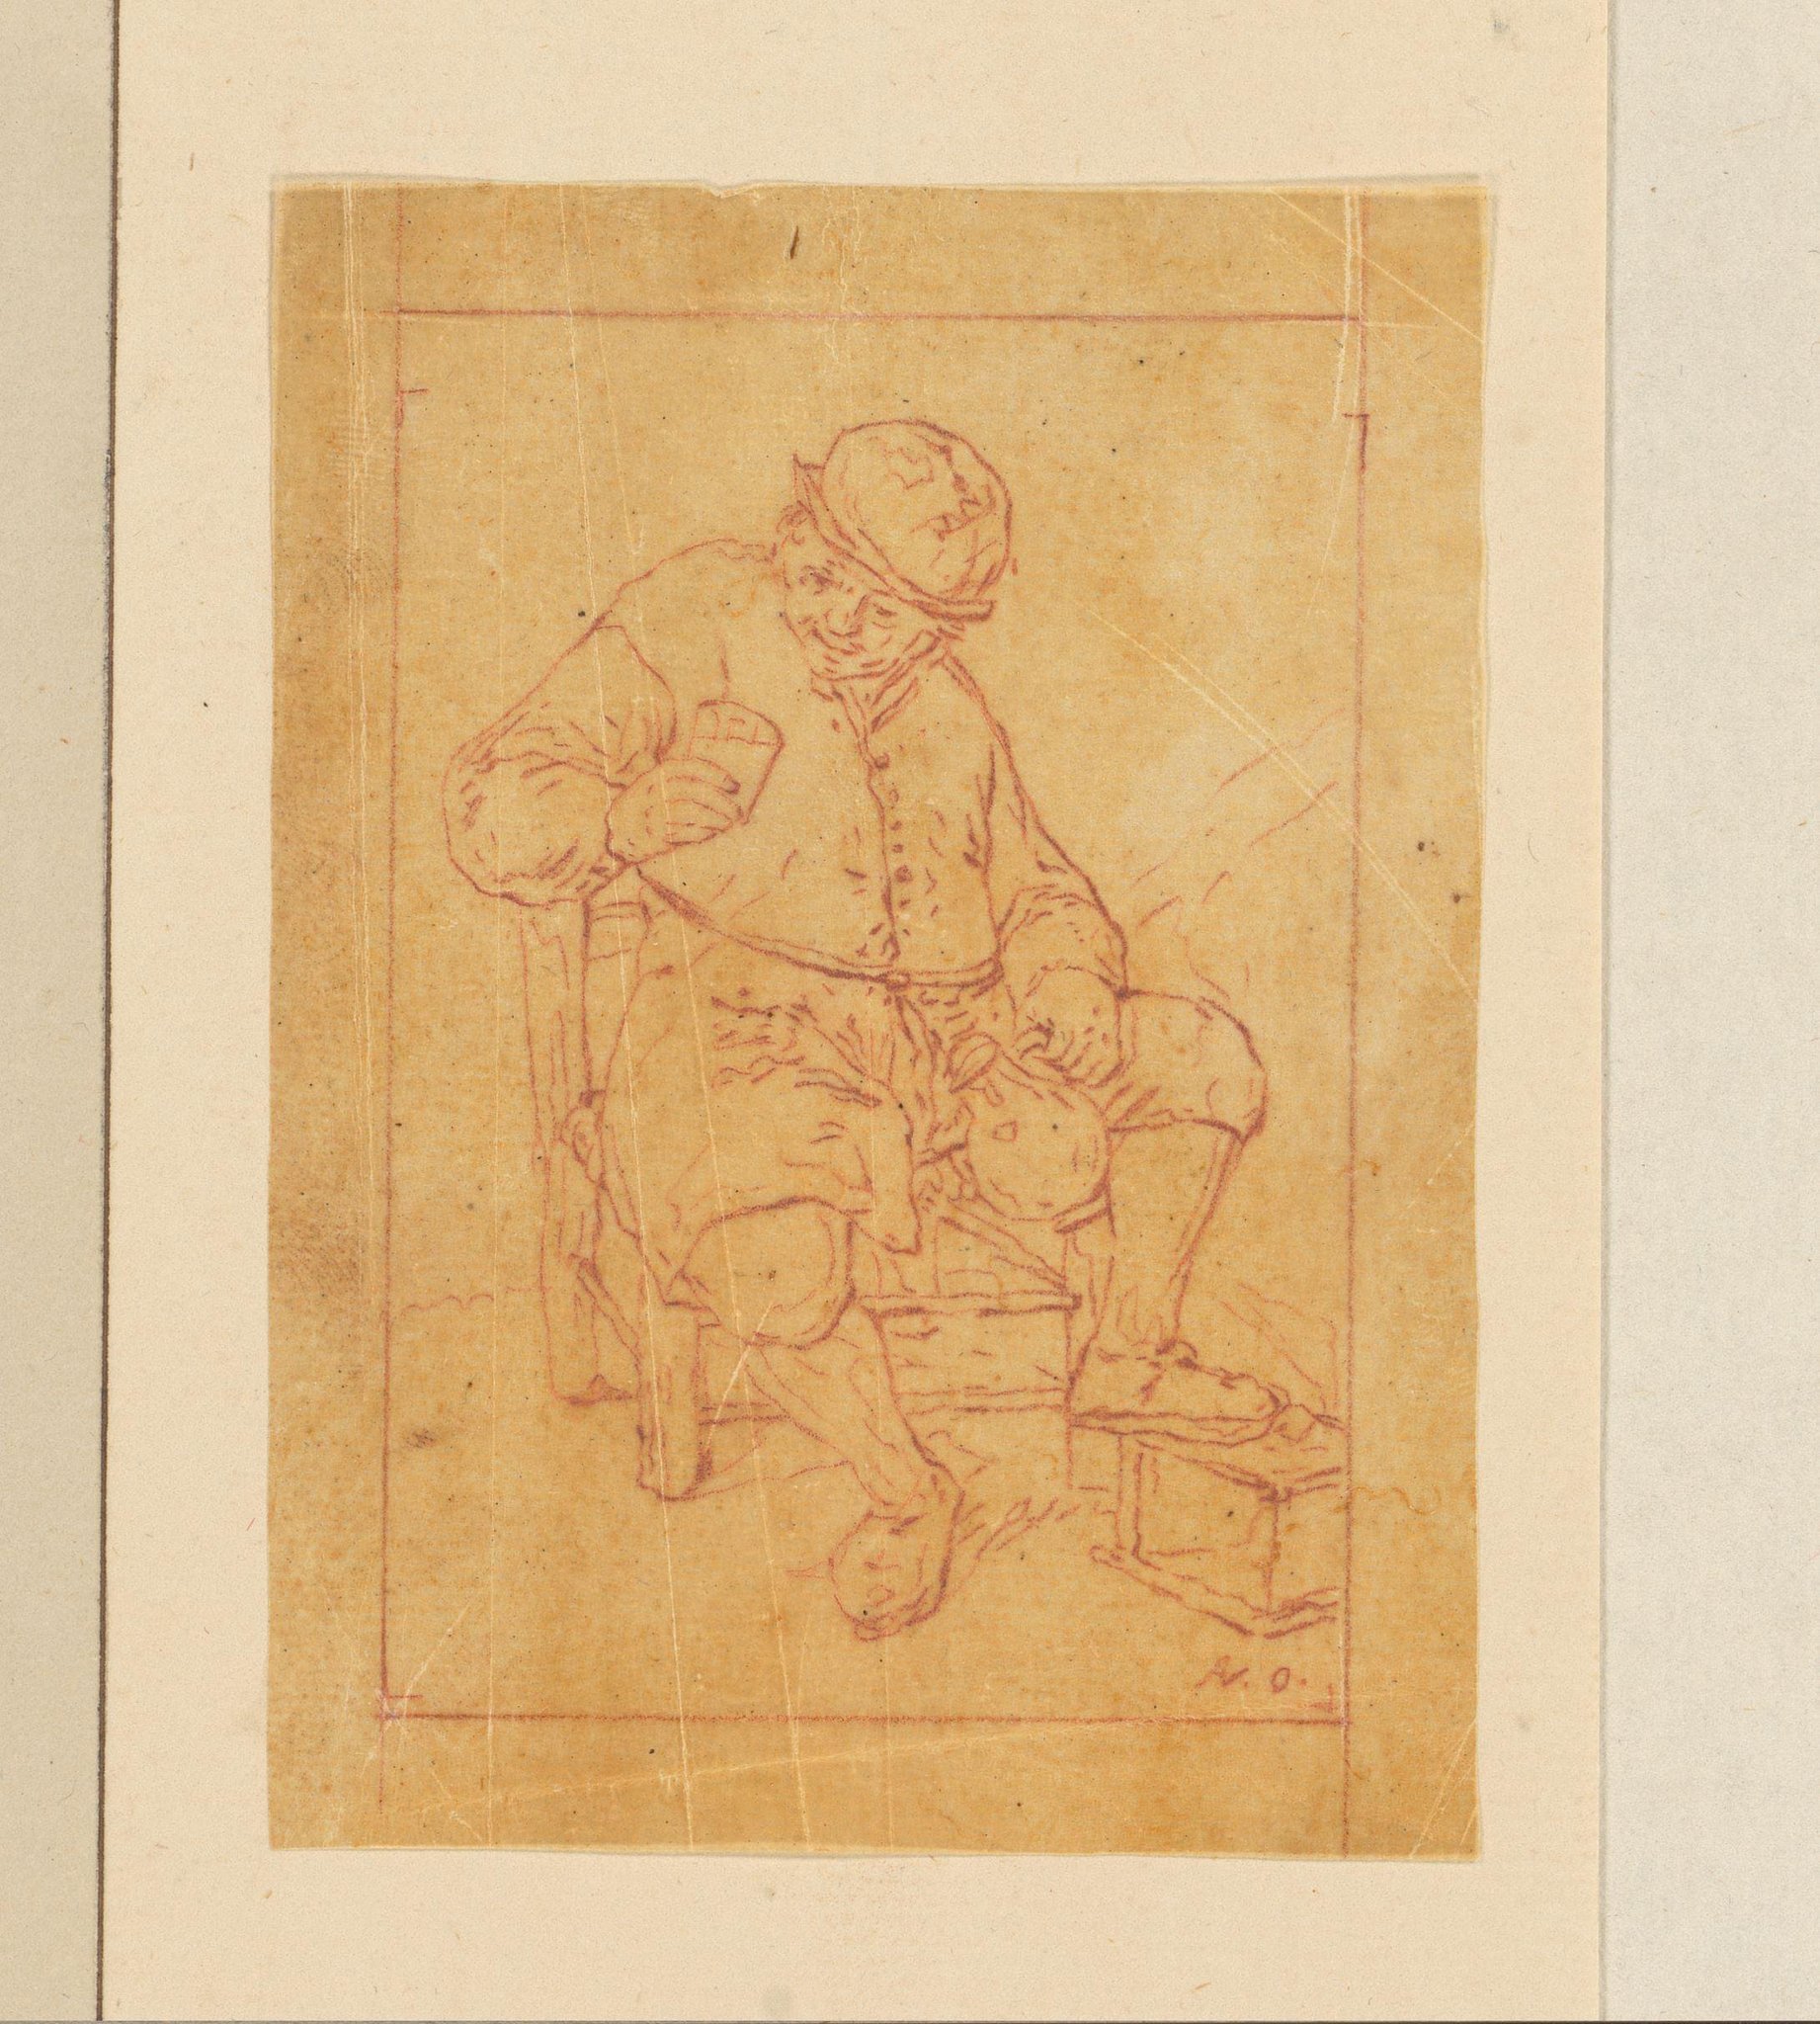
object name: tracing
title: Zittende boer met kruik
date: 1739-1798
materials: chalk, paper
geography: amsterdam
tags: sitting figure, jar, jug (used as drinking-vessel)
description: Een boer zit op een stoel met een glas in de ene en een kruik in de andere hand. De calque ligt los in een album, zie blad 62.